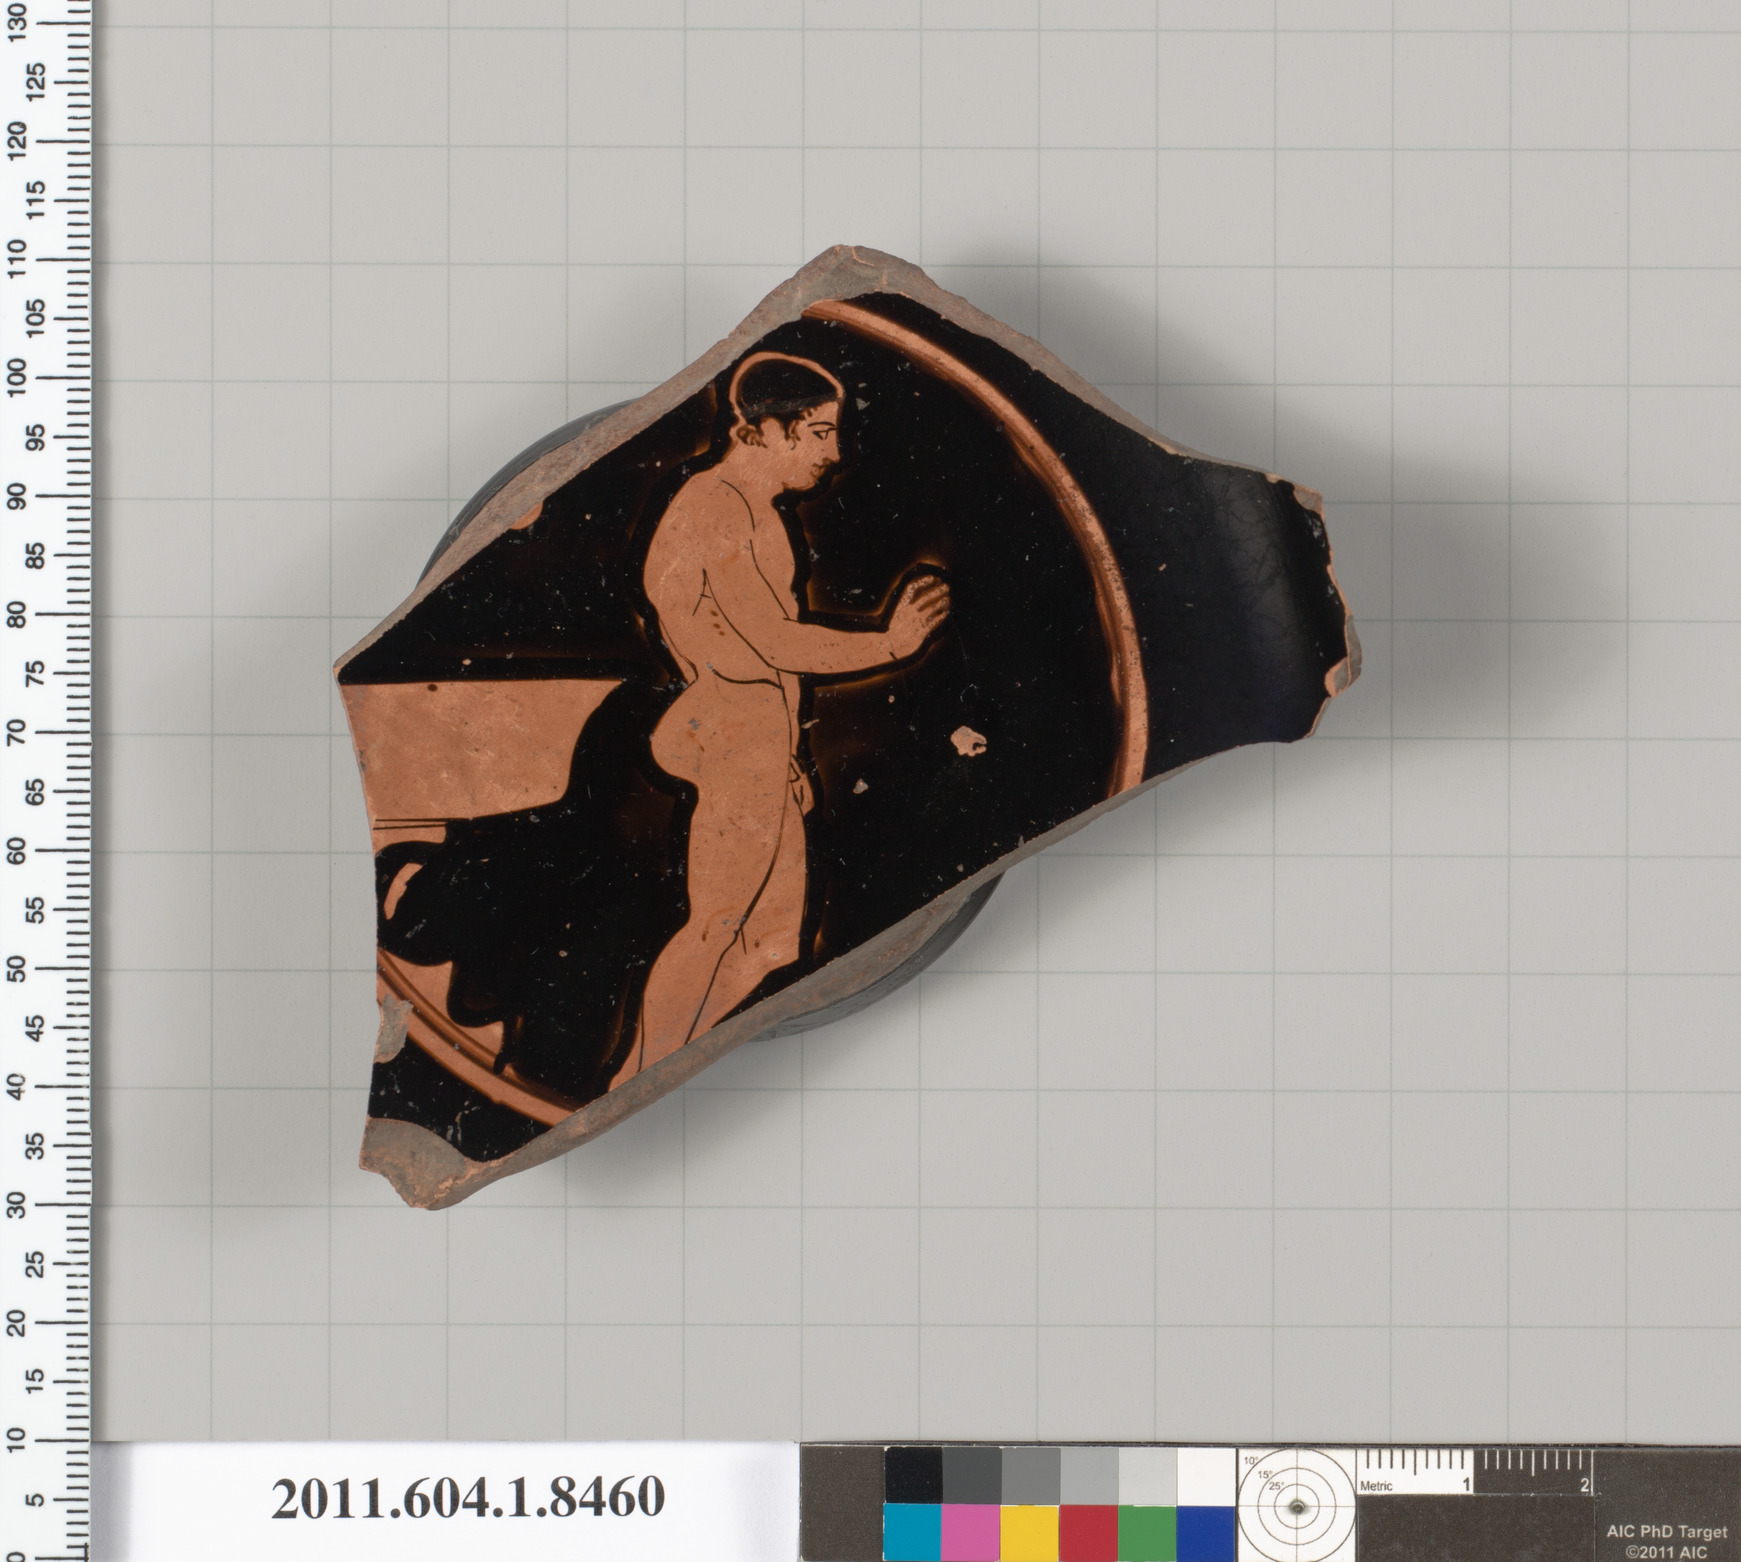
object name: kylix fragment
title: Terracotta fragment of a stemless kylix (drinking cup)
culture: greek, attic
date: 460-450 BCE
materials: terracotta